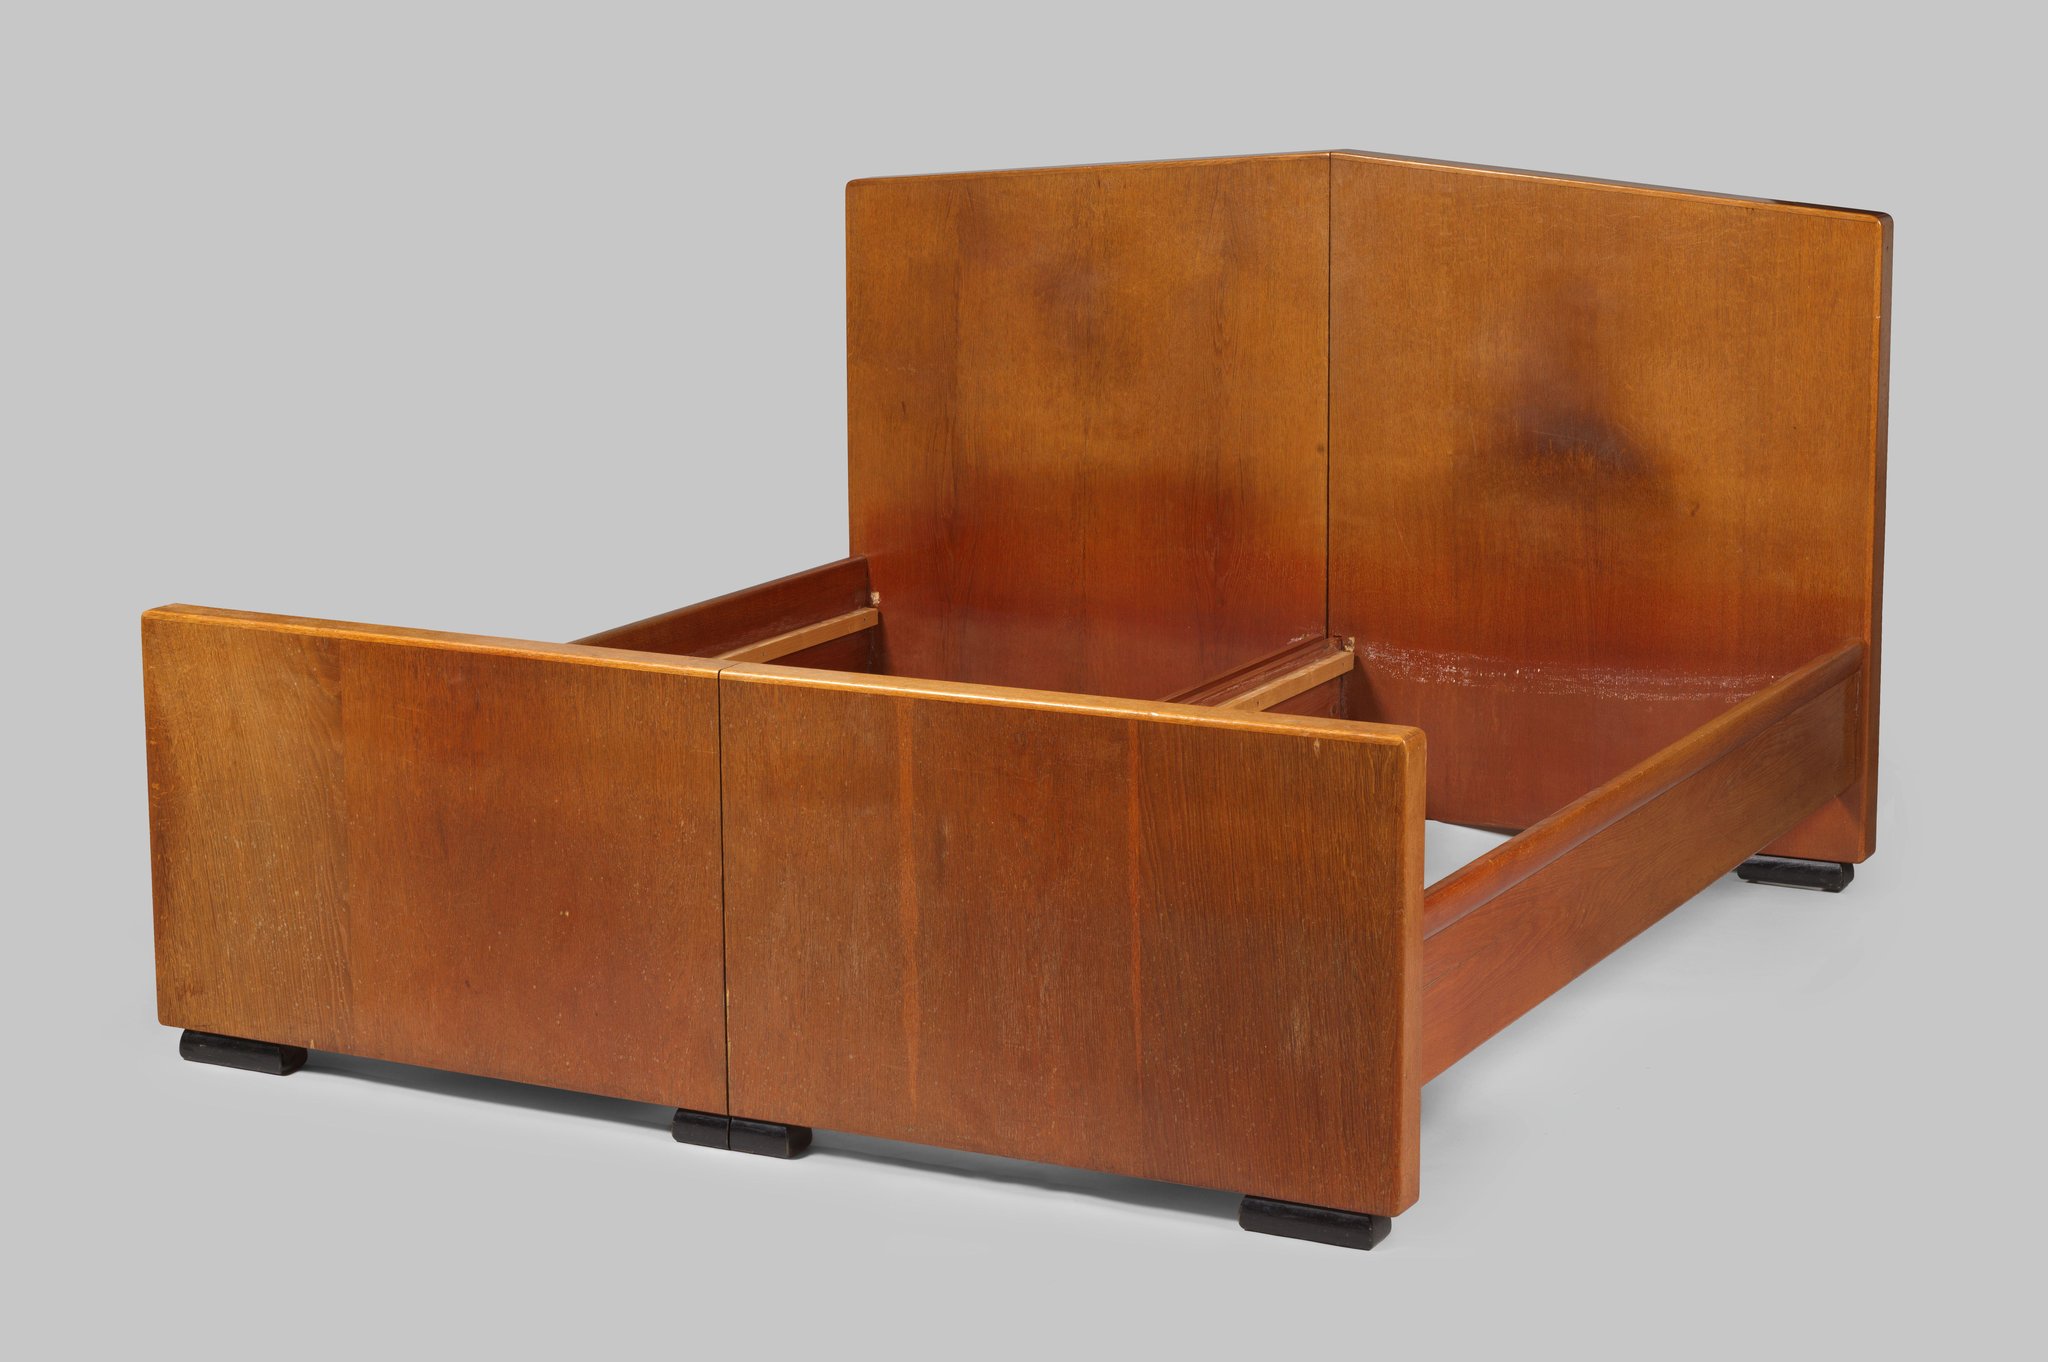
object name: bed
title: Lits-jumeaux van eiken- en grenenhout en zwart getint without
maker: piet l. kramer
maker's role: architect, interieurontwerper, meubelontwerper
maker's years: 1881-1961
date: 1920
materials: wood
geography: netherlands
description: Lits-jumeaux van eiken- en grenenhout en zwart getint without. Ontwerp P. Kramer. Ca. 1920. Ligmeubel.